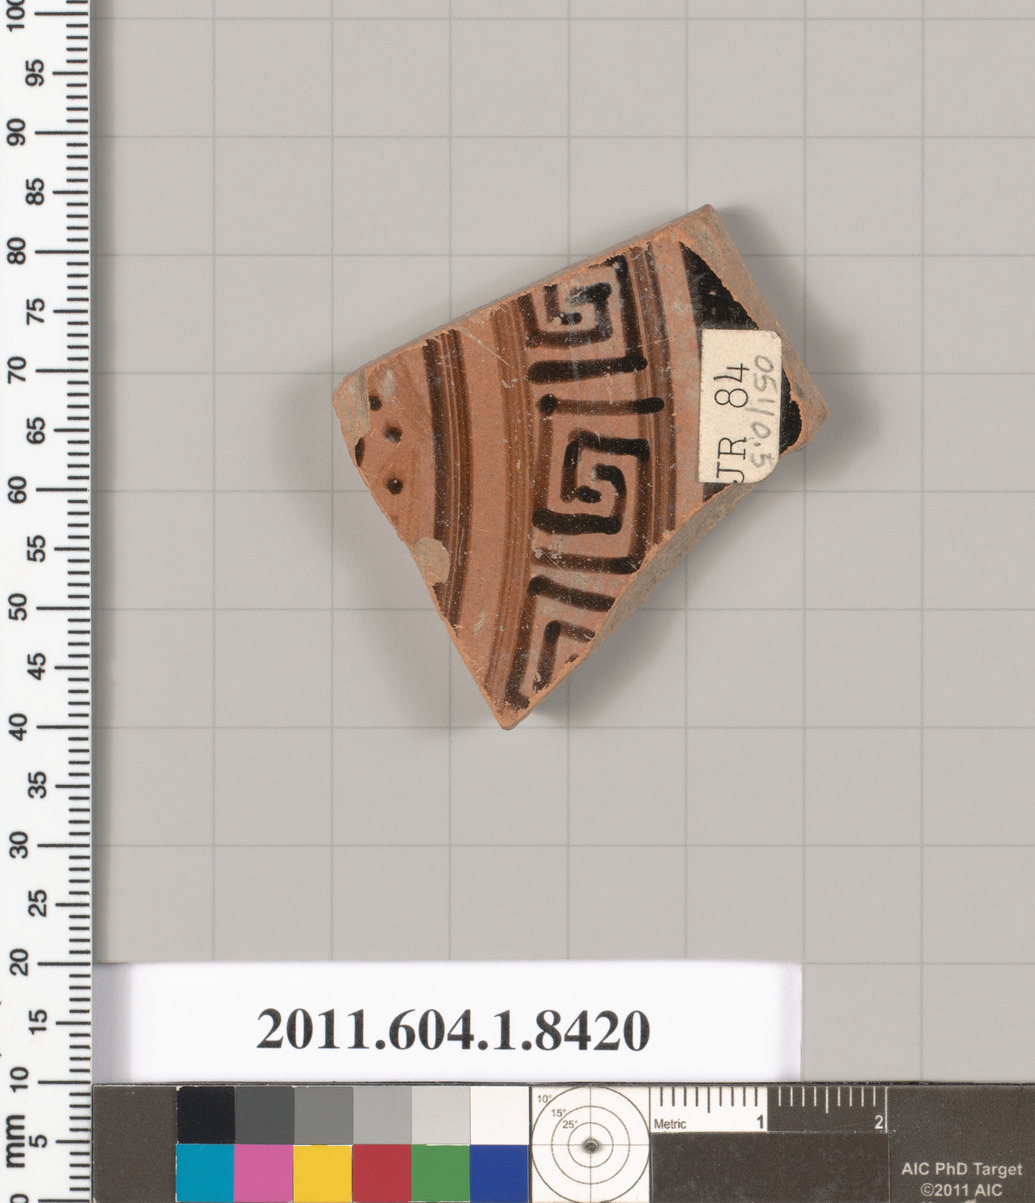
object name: kylix fragment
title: Terracotta fragment of a kylix (drinking cup)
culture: greek, attic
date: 375-351 BCE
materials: terracotta